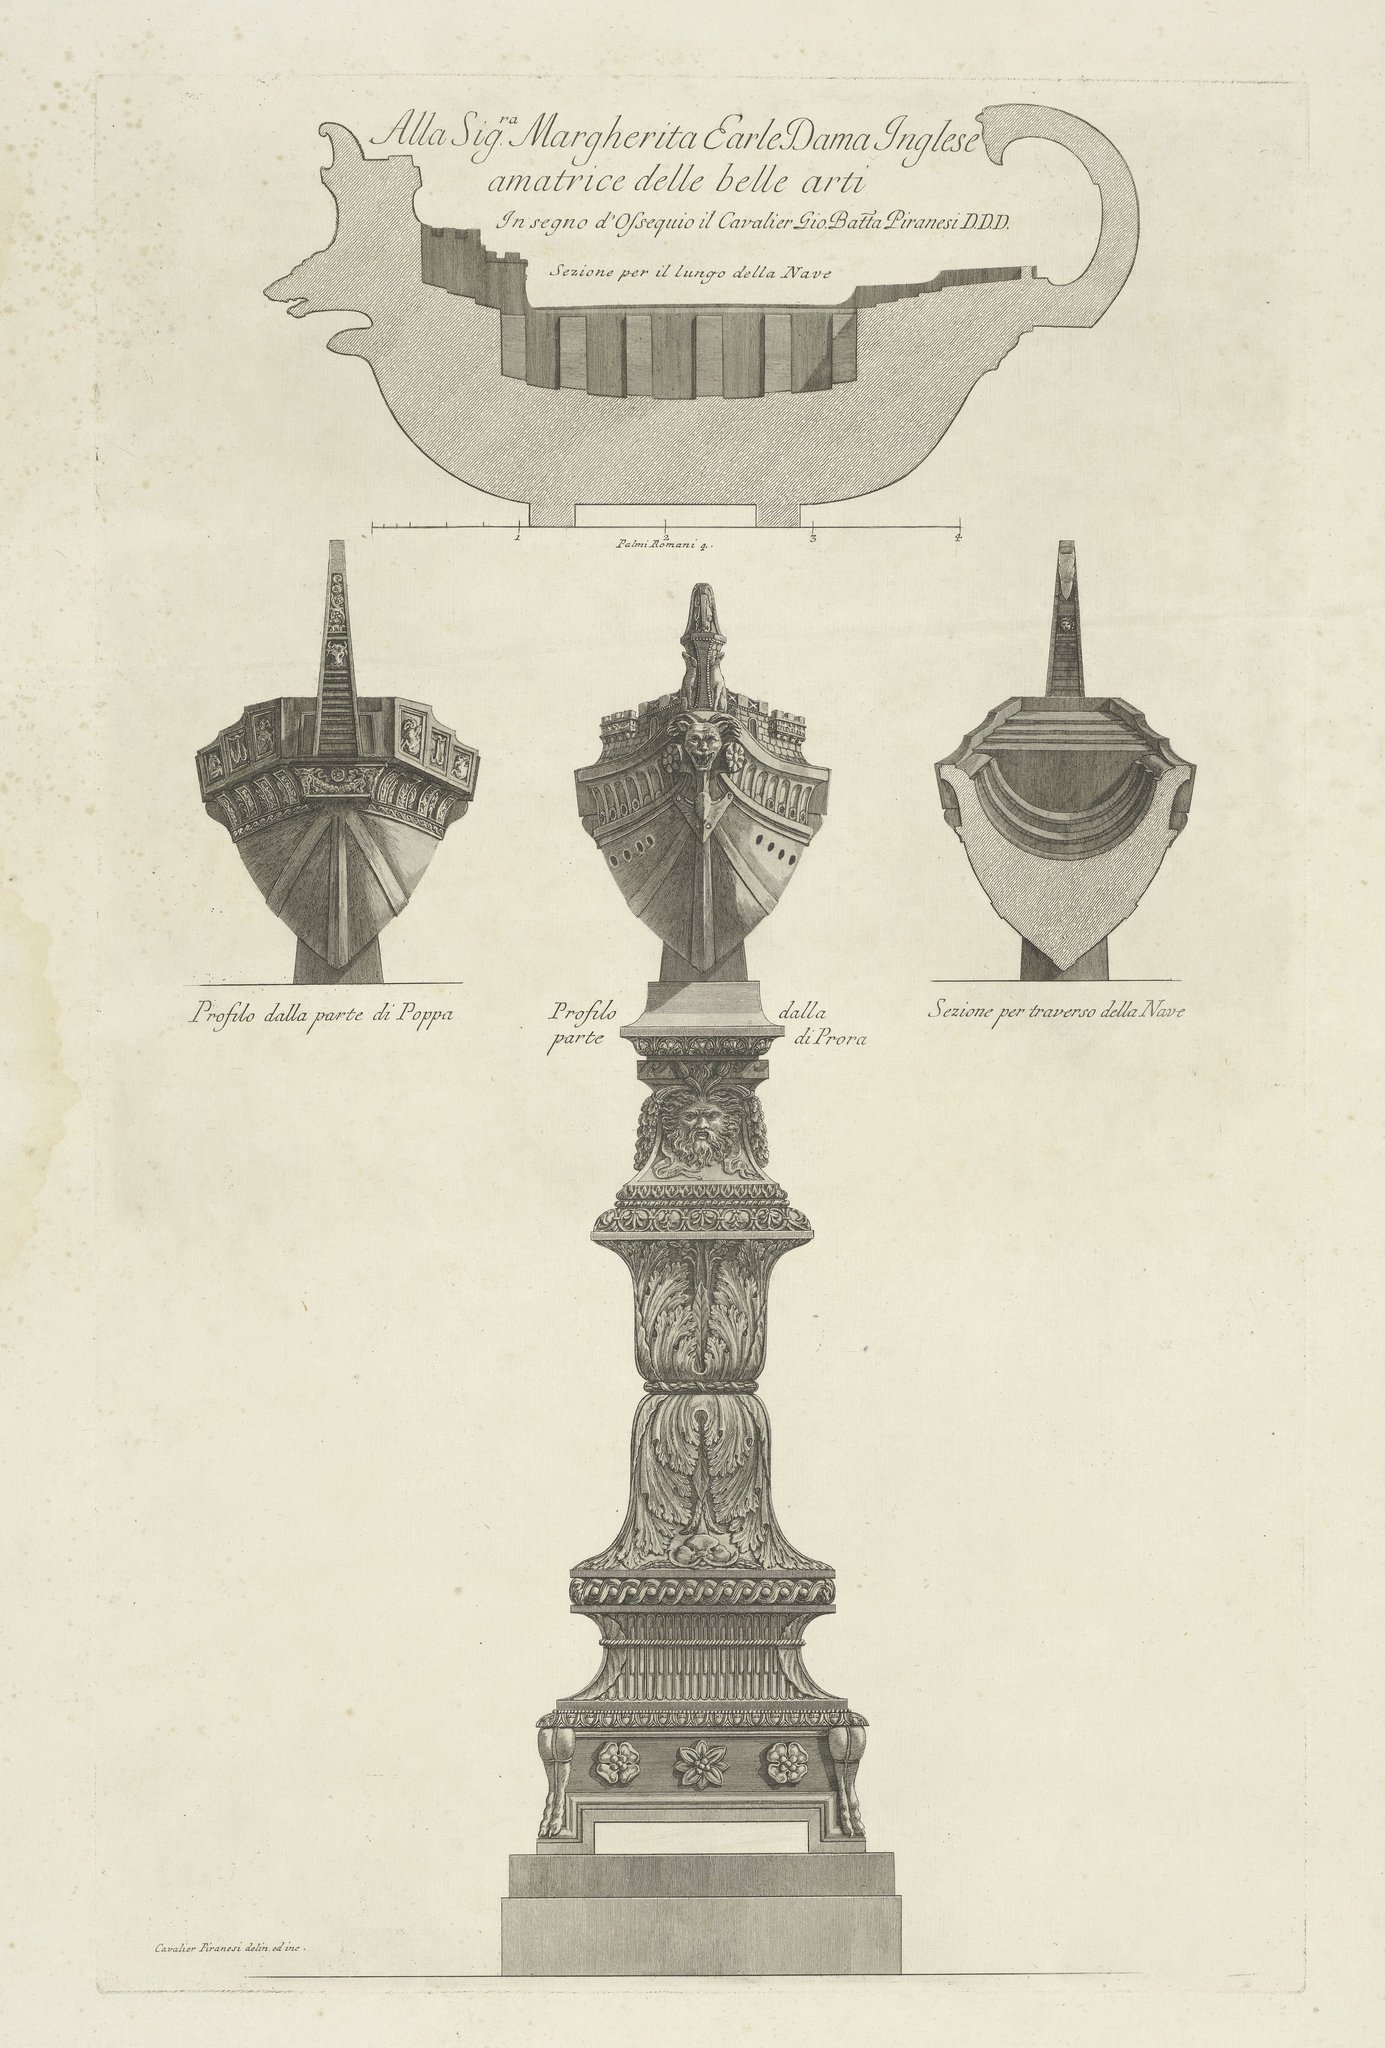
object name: print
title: Vasi, candelabri, cippi, sarcofagi, tripodi, lucerne, ed ornamenti antichi disegn. ed incisi dal cav. Gio. Batta Piranesi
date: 1778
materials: paper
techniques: etching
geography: rome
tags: military vehicles (+ naval force), piece of sculpture, reproduction of a piece of sculpture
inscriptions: collector's mark: Lugt 2228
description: De 'Vasi'-reeks telt 110 prenten, verspreid over twee volumes met elk een eigen titelprent. Piranesi werd voor deze reeks geholpen door verschillende assistenten uit zijn werkplaats, waaronder zijn zoon Francesco die ook nog eens 8 platen toevoegde aan de reeks in 1779-1780.